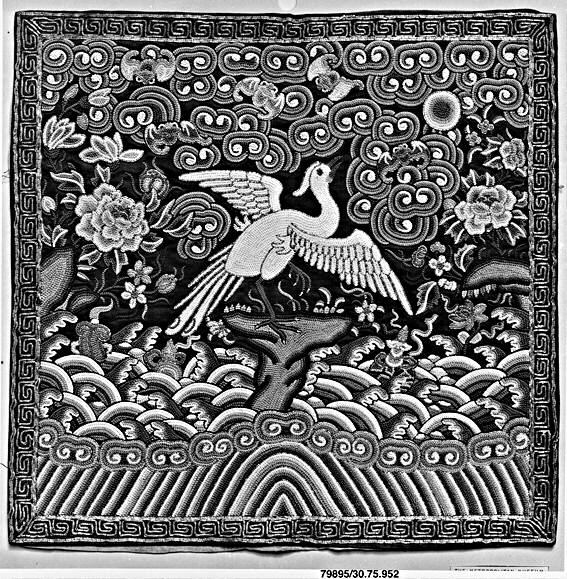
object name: rank badge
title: Rank Badge with Paradise Fly-Catcher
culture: chinese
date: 1767-1833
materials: metal thread, silk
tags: bats,birds